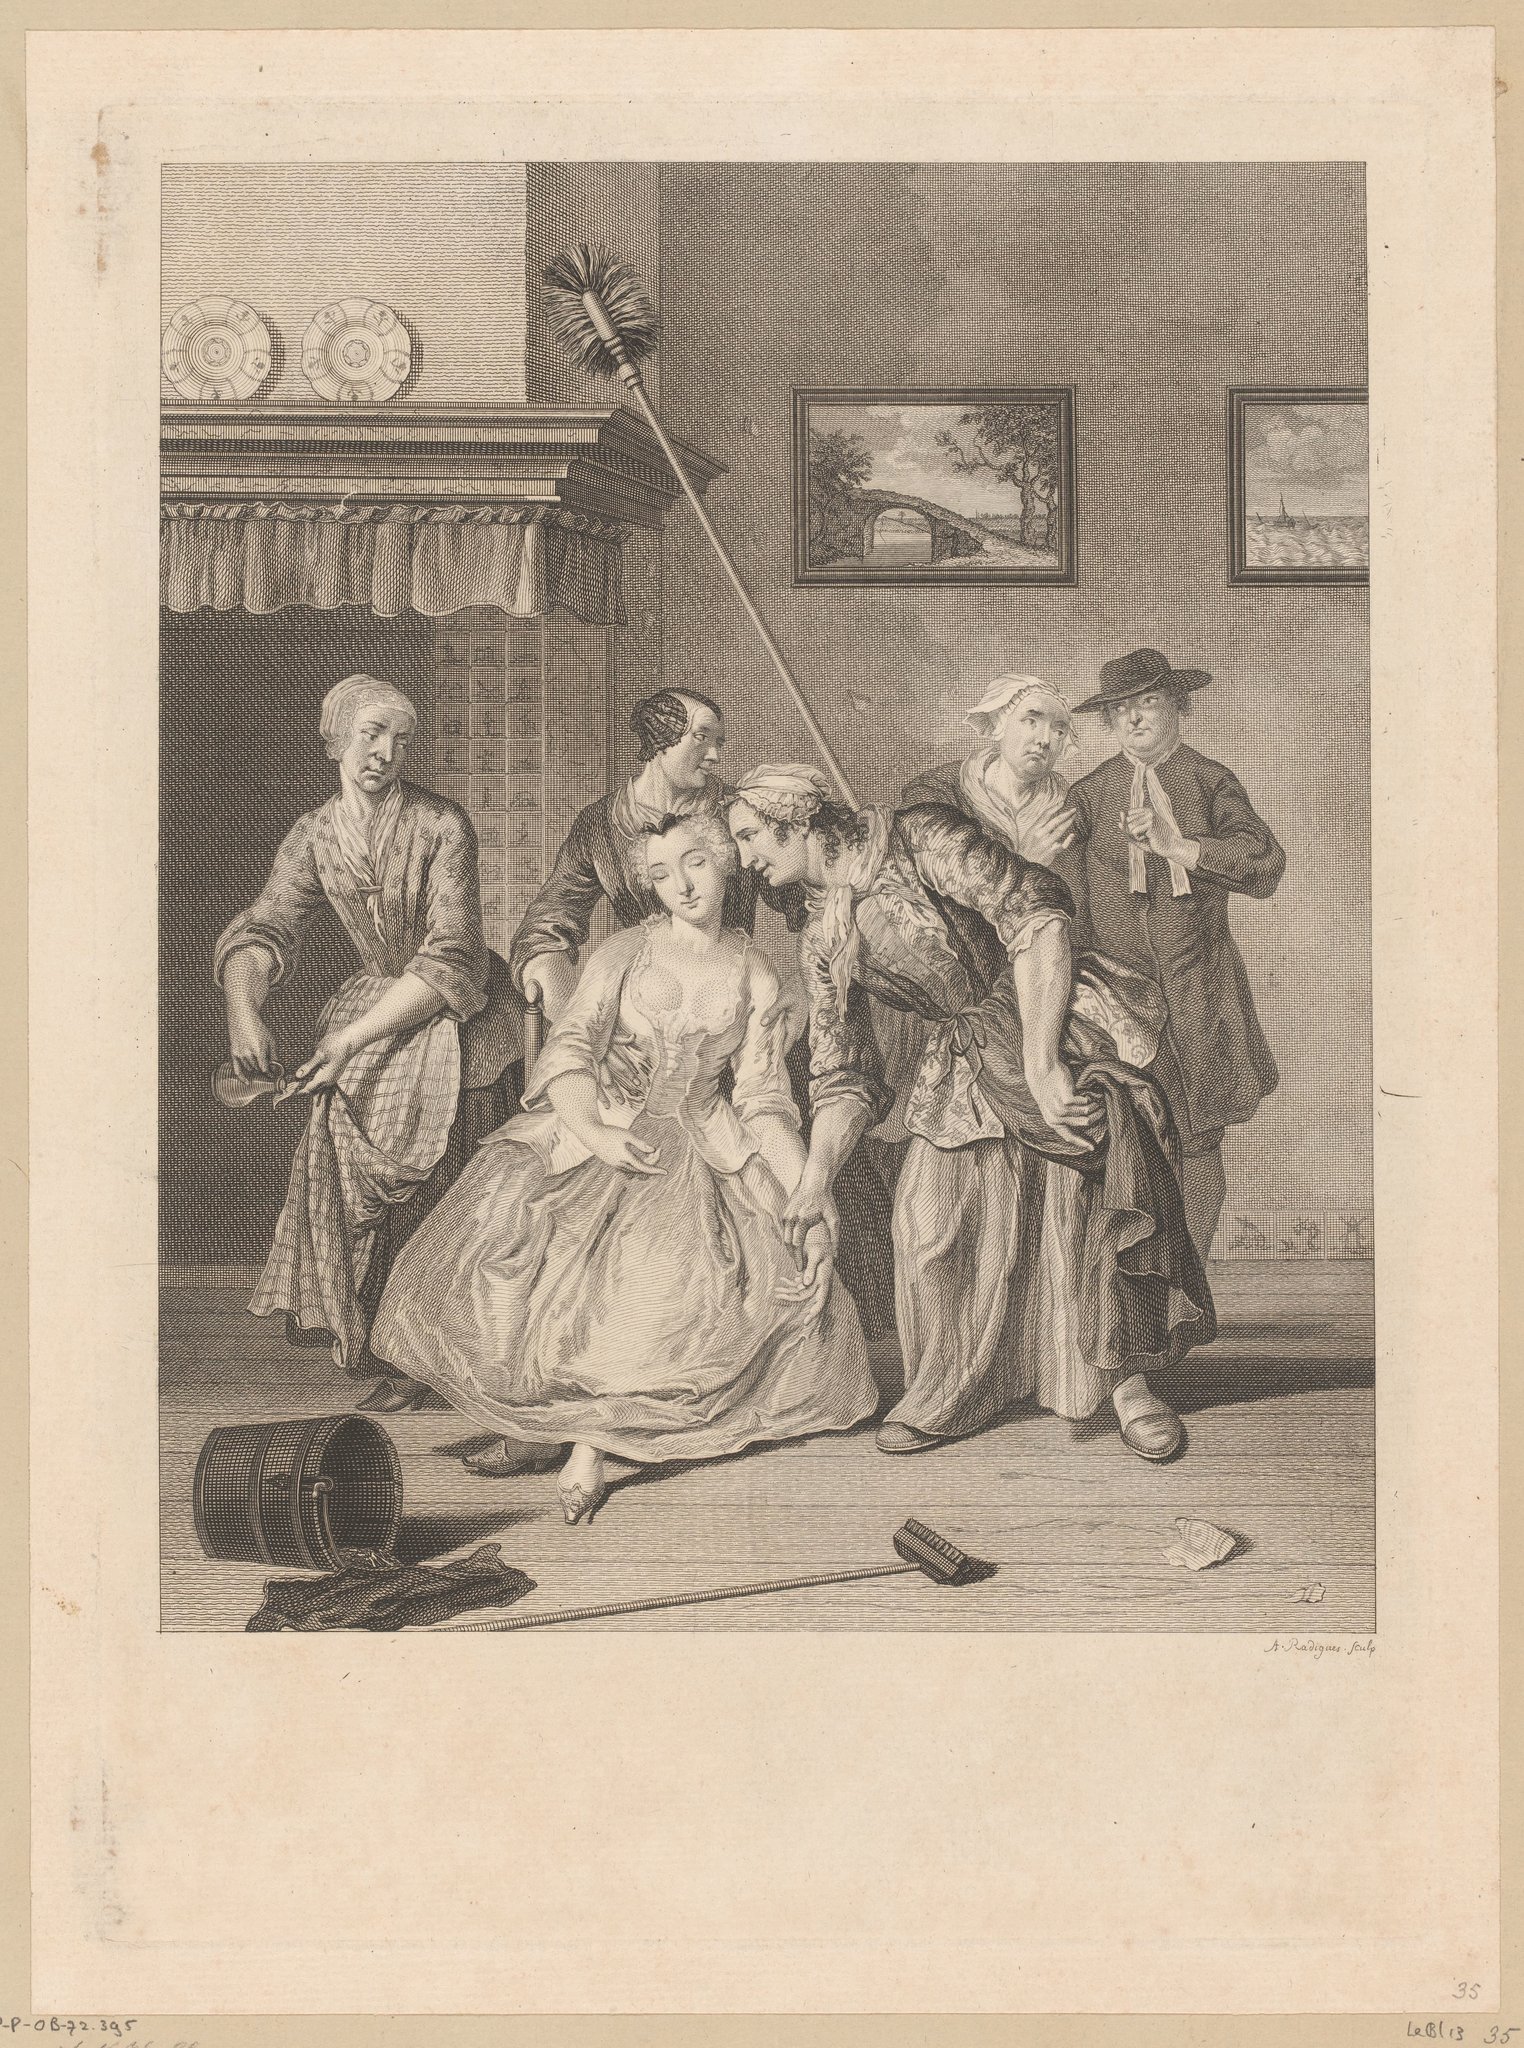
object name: print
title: Jan Klaaszen, of de gewaande Dienstmaagd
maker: antoine radigues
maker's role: print maker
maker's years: 1721-1809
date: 1757-1764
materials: paper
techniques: engraving, etching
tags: man dressed as woman, travesty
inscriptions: collector's mark: Lugt 240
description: Saartje valt in zwijm als ontdekt wordt dat haar geliefde Jan Klaaszen zich vermomd had als dienstmeid, om zo bij haar te kunnen zijn.